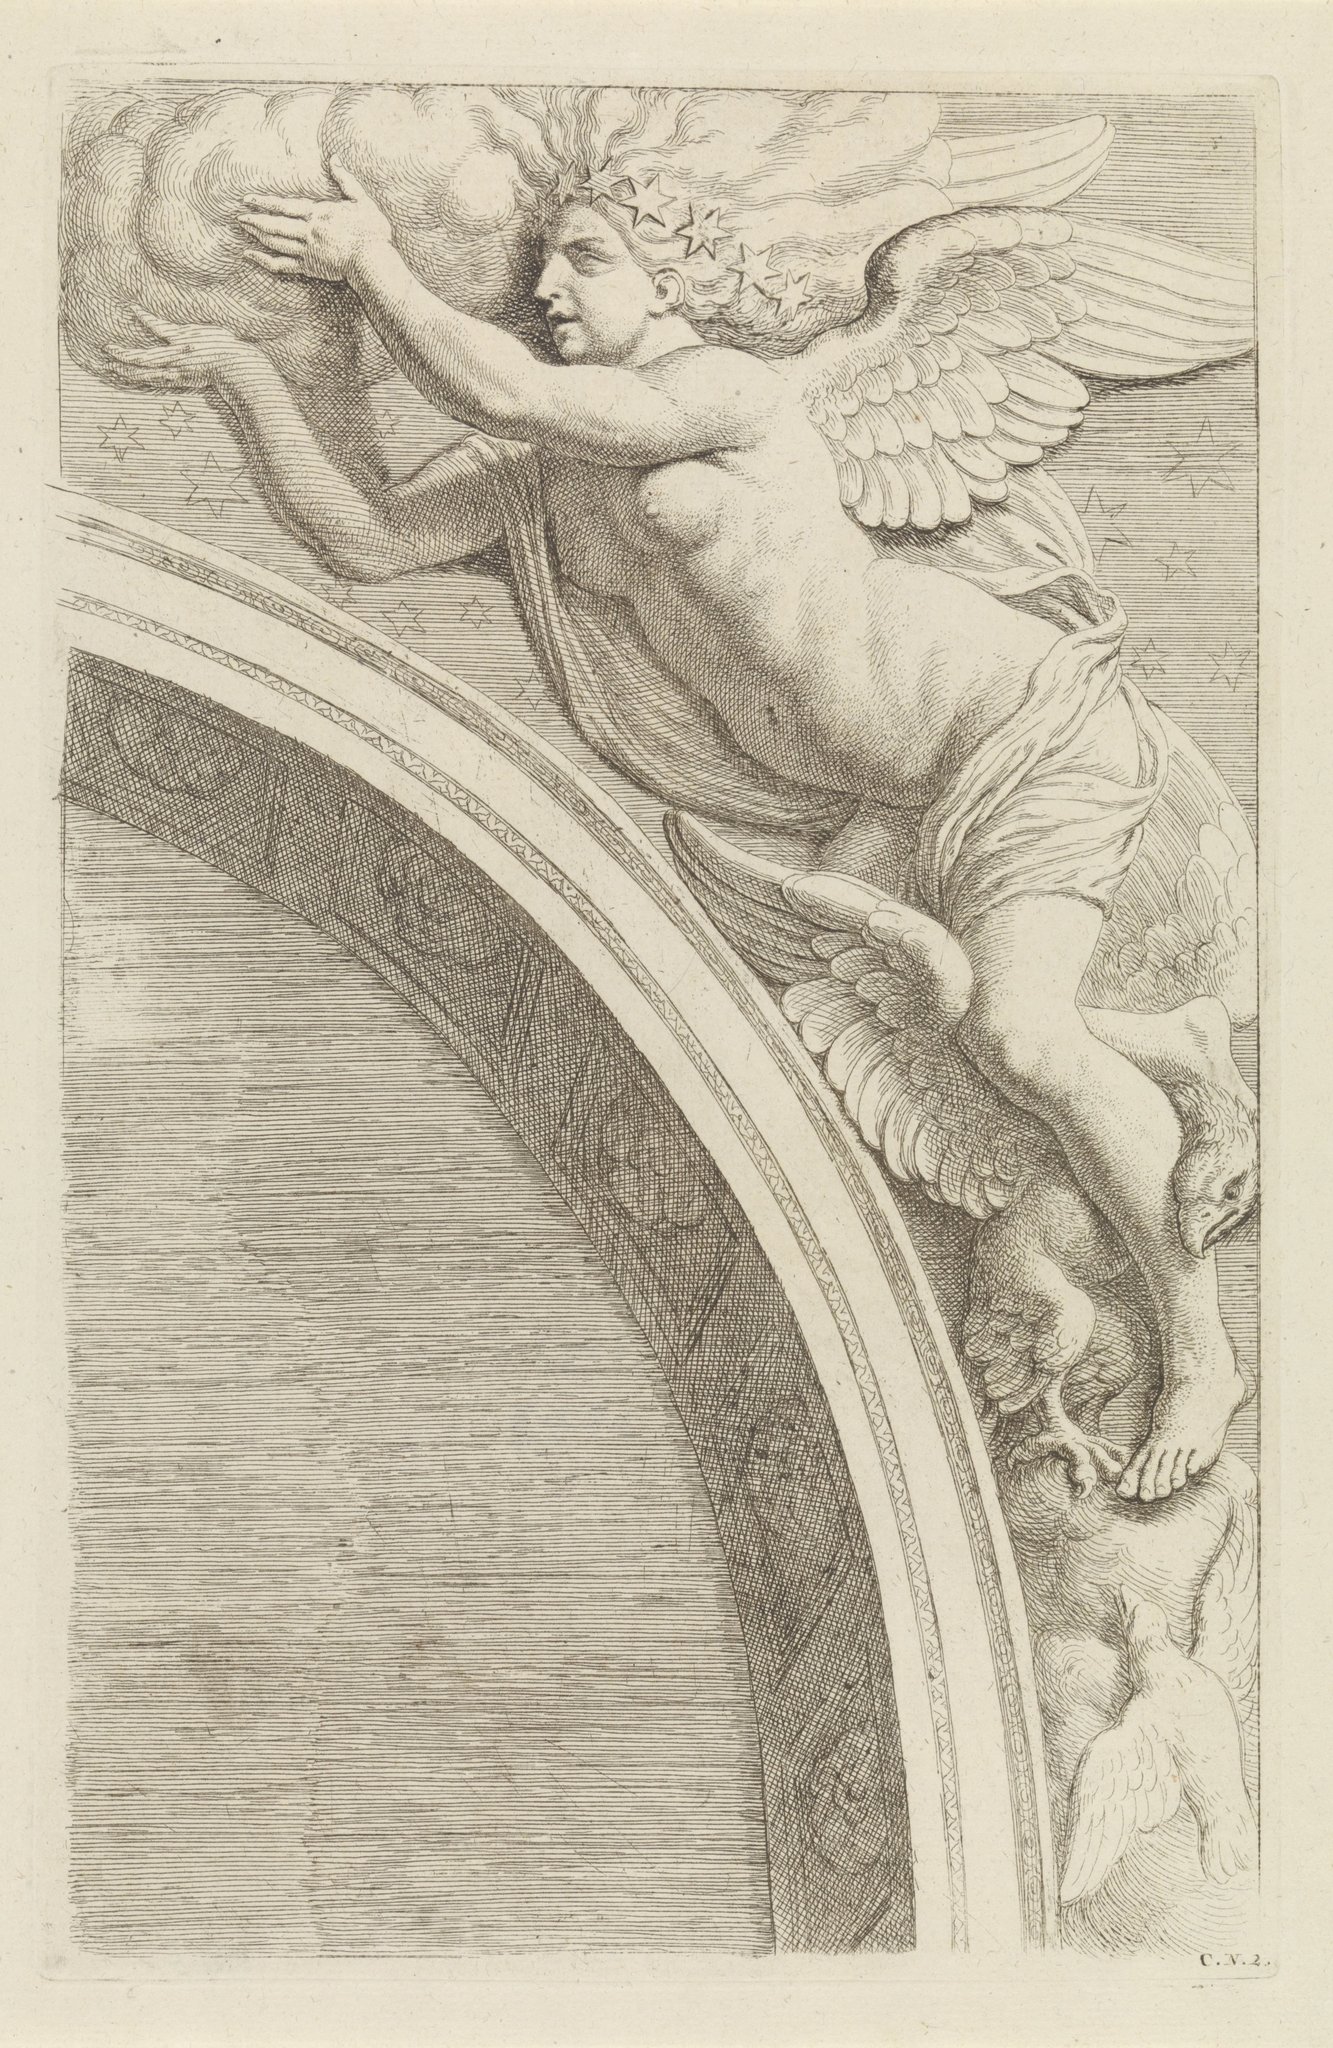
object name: book illustration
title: Reliëf met personificatie van het element Lucht boven boog in de Burgerzaal van het Stadhuis op de Dam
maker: hubert quellinus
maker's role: print maker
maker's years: 1619-1687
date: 1663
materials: paper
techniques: engraving, etching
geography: amsterdam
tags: predatory birds: eagle, clouds, air (one of the four elements), birds, stars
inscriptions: collector's mark: Lugt 2228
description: Huidige staat van prent ook gebruikt in: Architecture peinture et sculpture de la Maison de Ville d'Amsterdam, representee en CIX. figures en taille-douce (…). Amsterdam: David Mortier, 1719. En in: Architecture peinture et sculpture de la Maison de Ville d'Amsterdam, representee en CIX. figures en taille-douce (…). Amsterdam: Gerard Valck, 1719. En in: Bouw schilder en beeldhouwkonst, van het Stadhuis te Amsteldam, vertoont in CIX figuuren (…). Amsterdam: Covens & Mortier & Covens Jr., s.a. (1774-1783). Eerdere staat van prent ook gebruikt in: Secunca pars Praecipuarum effigierum ac ornamentorum amplissime Curiae Amstelrodamensis maiori ex parte in cadido marmore effectorum per Artum Quellinium eiusdem Civitatis Statuarium / Het tweede deel Van de voornaemste Statuen ende Cieraten van 't konst-rijcke Stadt-huys van Amstelredam 'tmeeste in Marmer gemaeckt door Artus Quellinus Beelthouwer der voorseyde Stadt. Amsterdam: Artus Quellinus (I), 1663. En in: Secunca pars Praecipuarum effigierum ac ornamentorum amplissime Curiae Amstelrodamensis maiori ex parte in cadido marmore effectorum per Artum Quellinium eiusdem Civitatis Statuarium / Het tweede deel Van de voornaemste Statuen ende Cieraten van 't konst-rijcke Stadt-huys van Amstelredam 'tmeeste in Marmer gemaeckt door Artus Quellinus Beelthouwer der voorseyde Stadt. Amsterdam: Frederik de Wit, 1668.